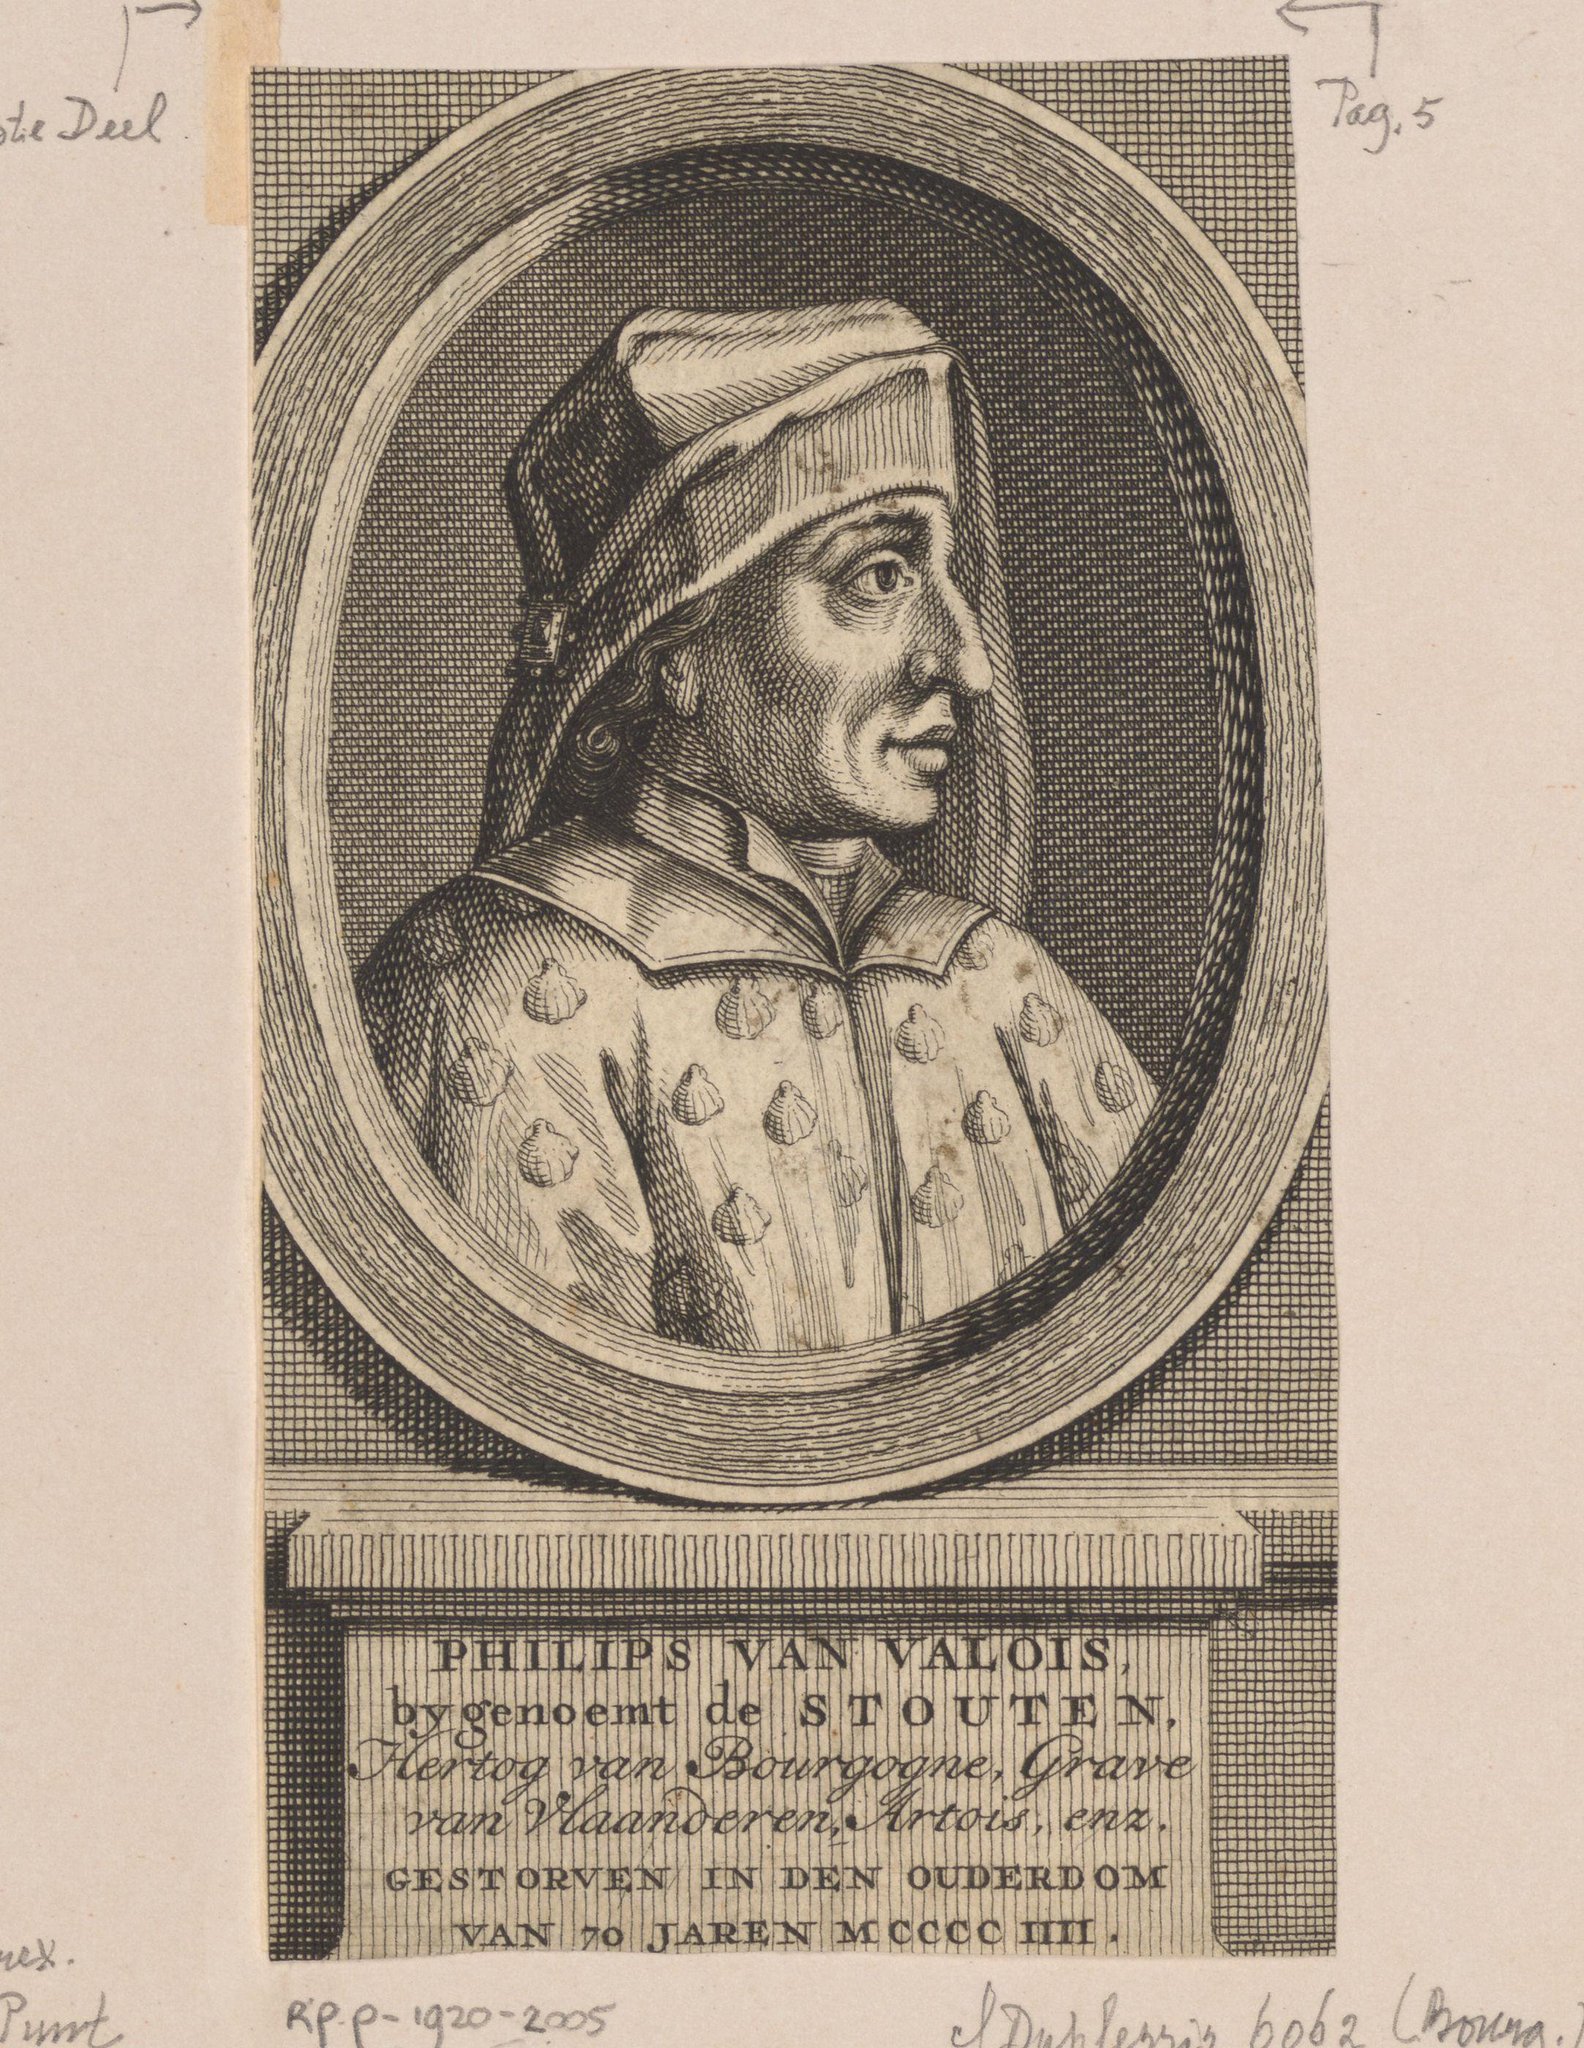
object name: print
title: Portret van Filips II de Stoute, hertog van Bourgondië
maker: jan punt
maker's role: draughtsman, print maker, publisher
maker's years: 1711-1779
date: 1747-1786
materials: paper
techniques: engraving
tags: halle, adult man, historical persons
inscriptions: collector's mark: Lugt 2228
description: Prent mogelijk uit: Meteren, Emmanuel van. Historie van de oorlogen en geschiedenissen der Nederlanderen, en derzelver naburen. Gorinchem en Breda: Nicolaas en Willem Goetzee, 1747, dl. 1. Of uit latere edities (1748, 1786).